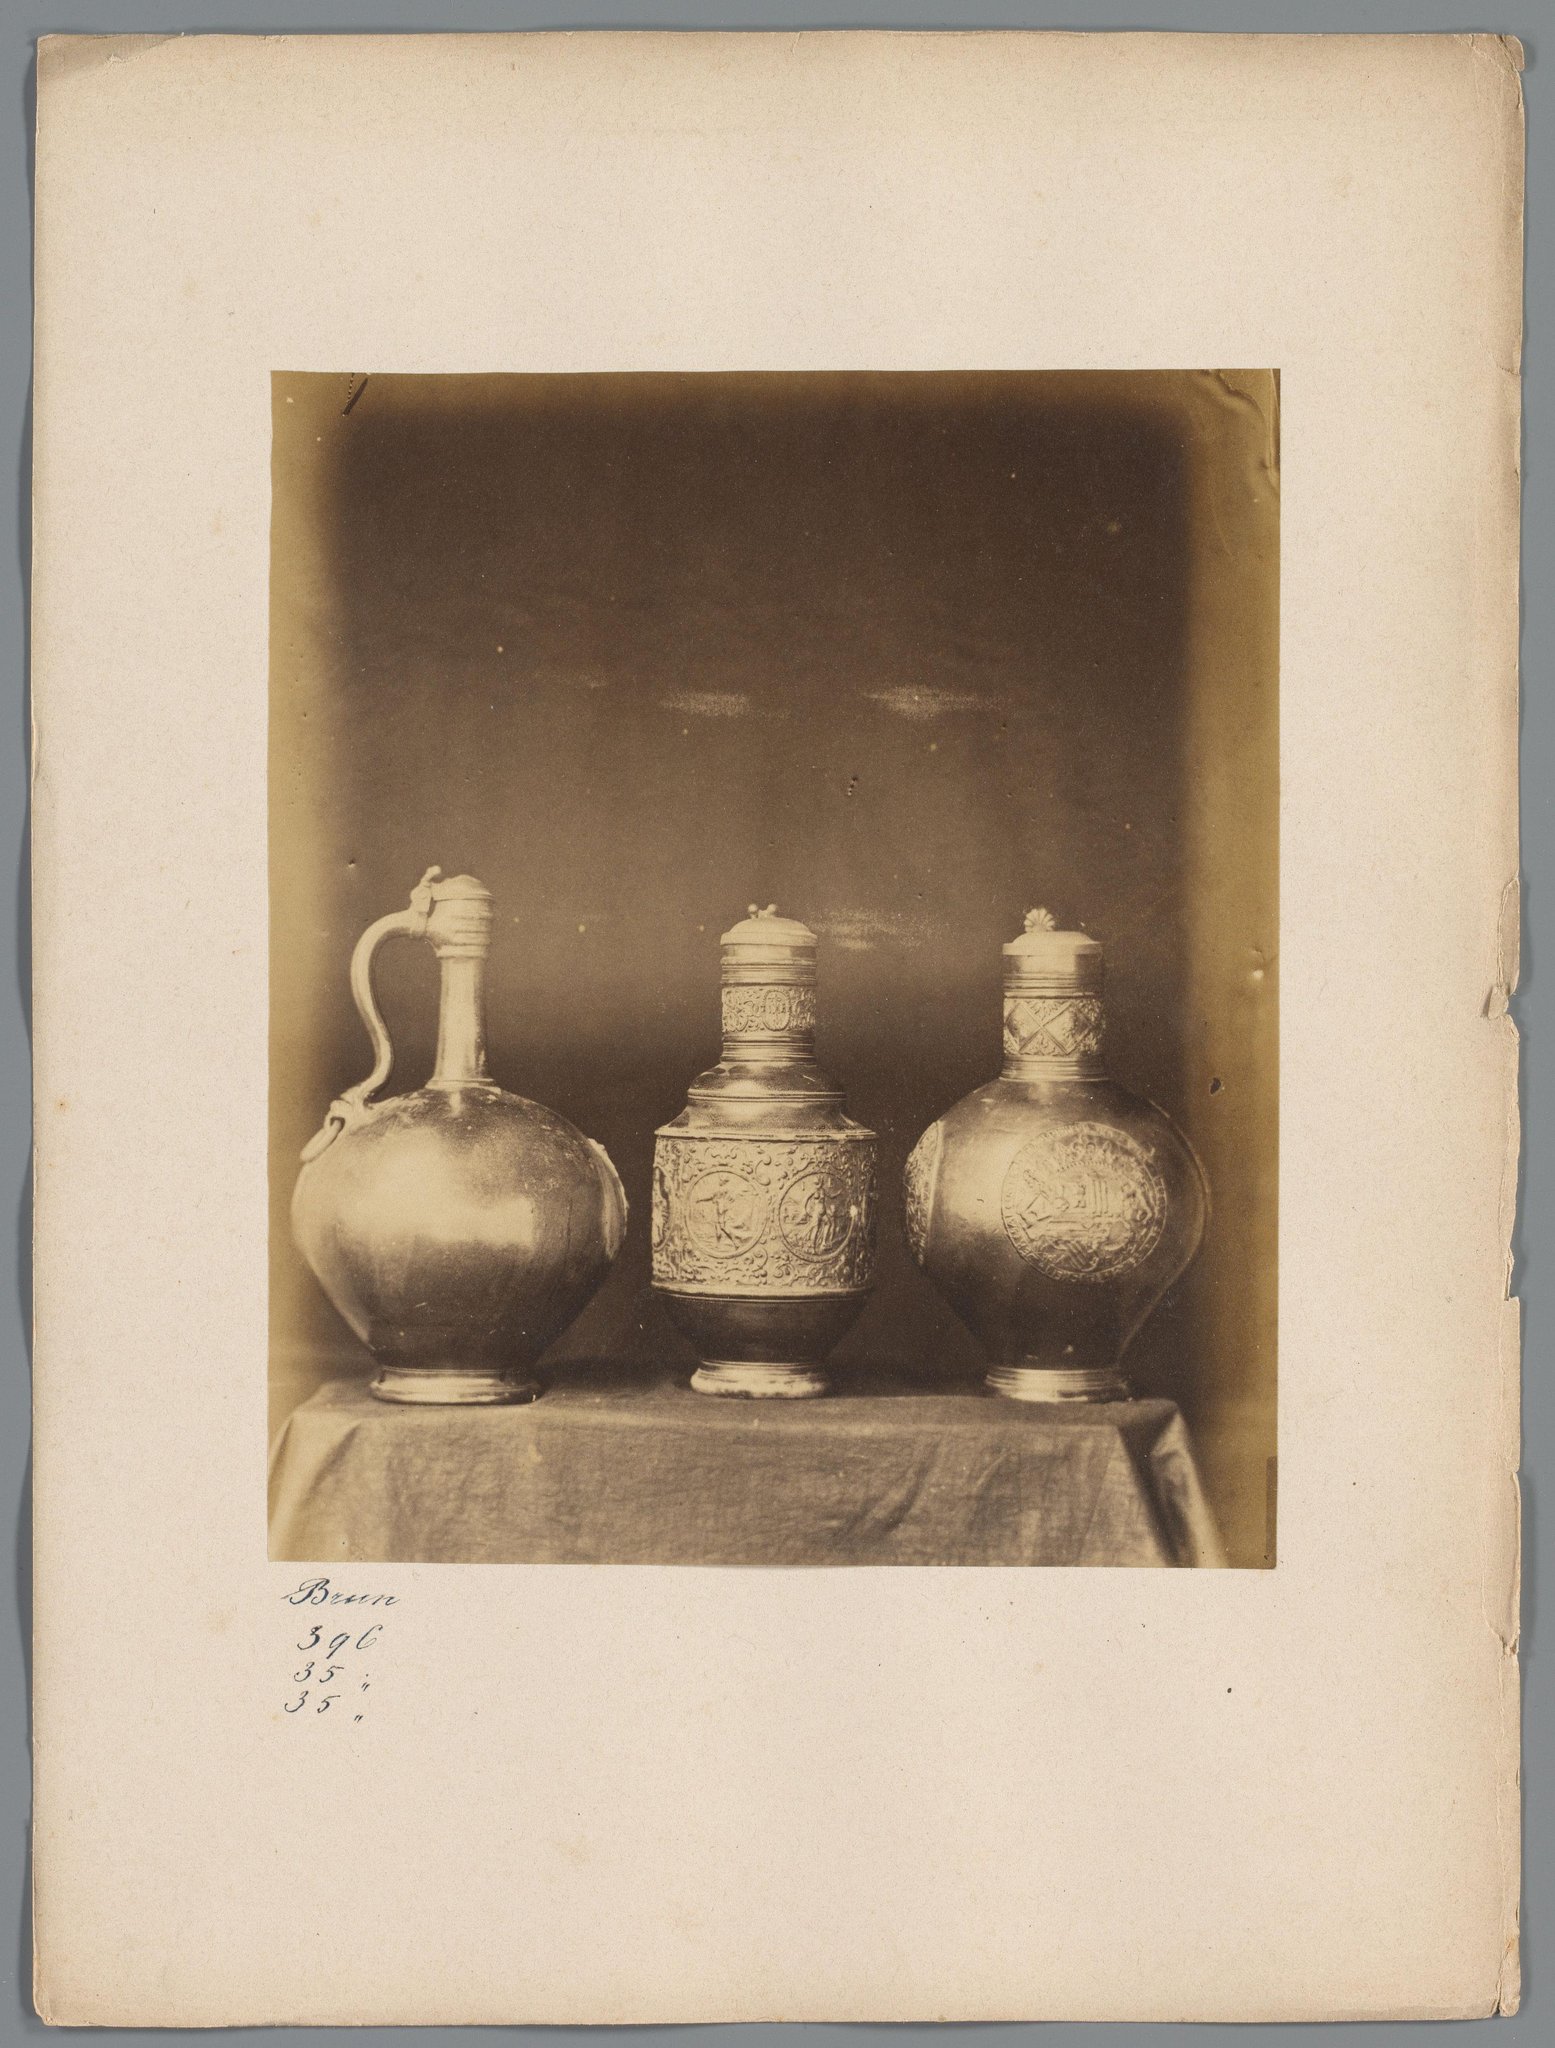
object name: photograph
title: Aardewerken vaas uit de collectie van W. de Weckherlin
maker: Anonymous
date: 1860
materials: paper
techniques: albumen print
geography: the hague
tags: container of ceramics: jar, jug, pot, vase, the hague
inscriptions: inscription: ‘Brun,/39C/ 35C/ 35C’